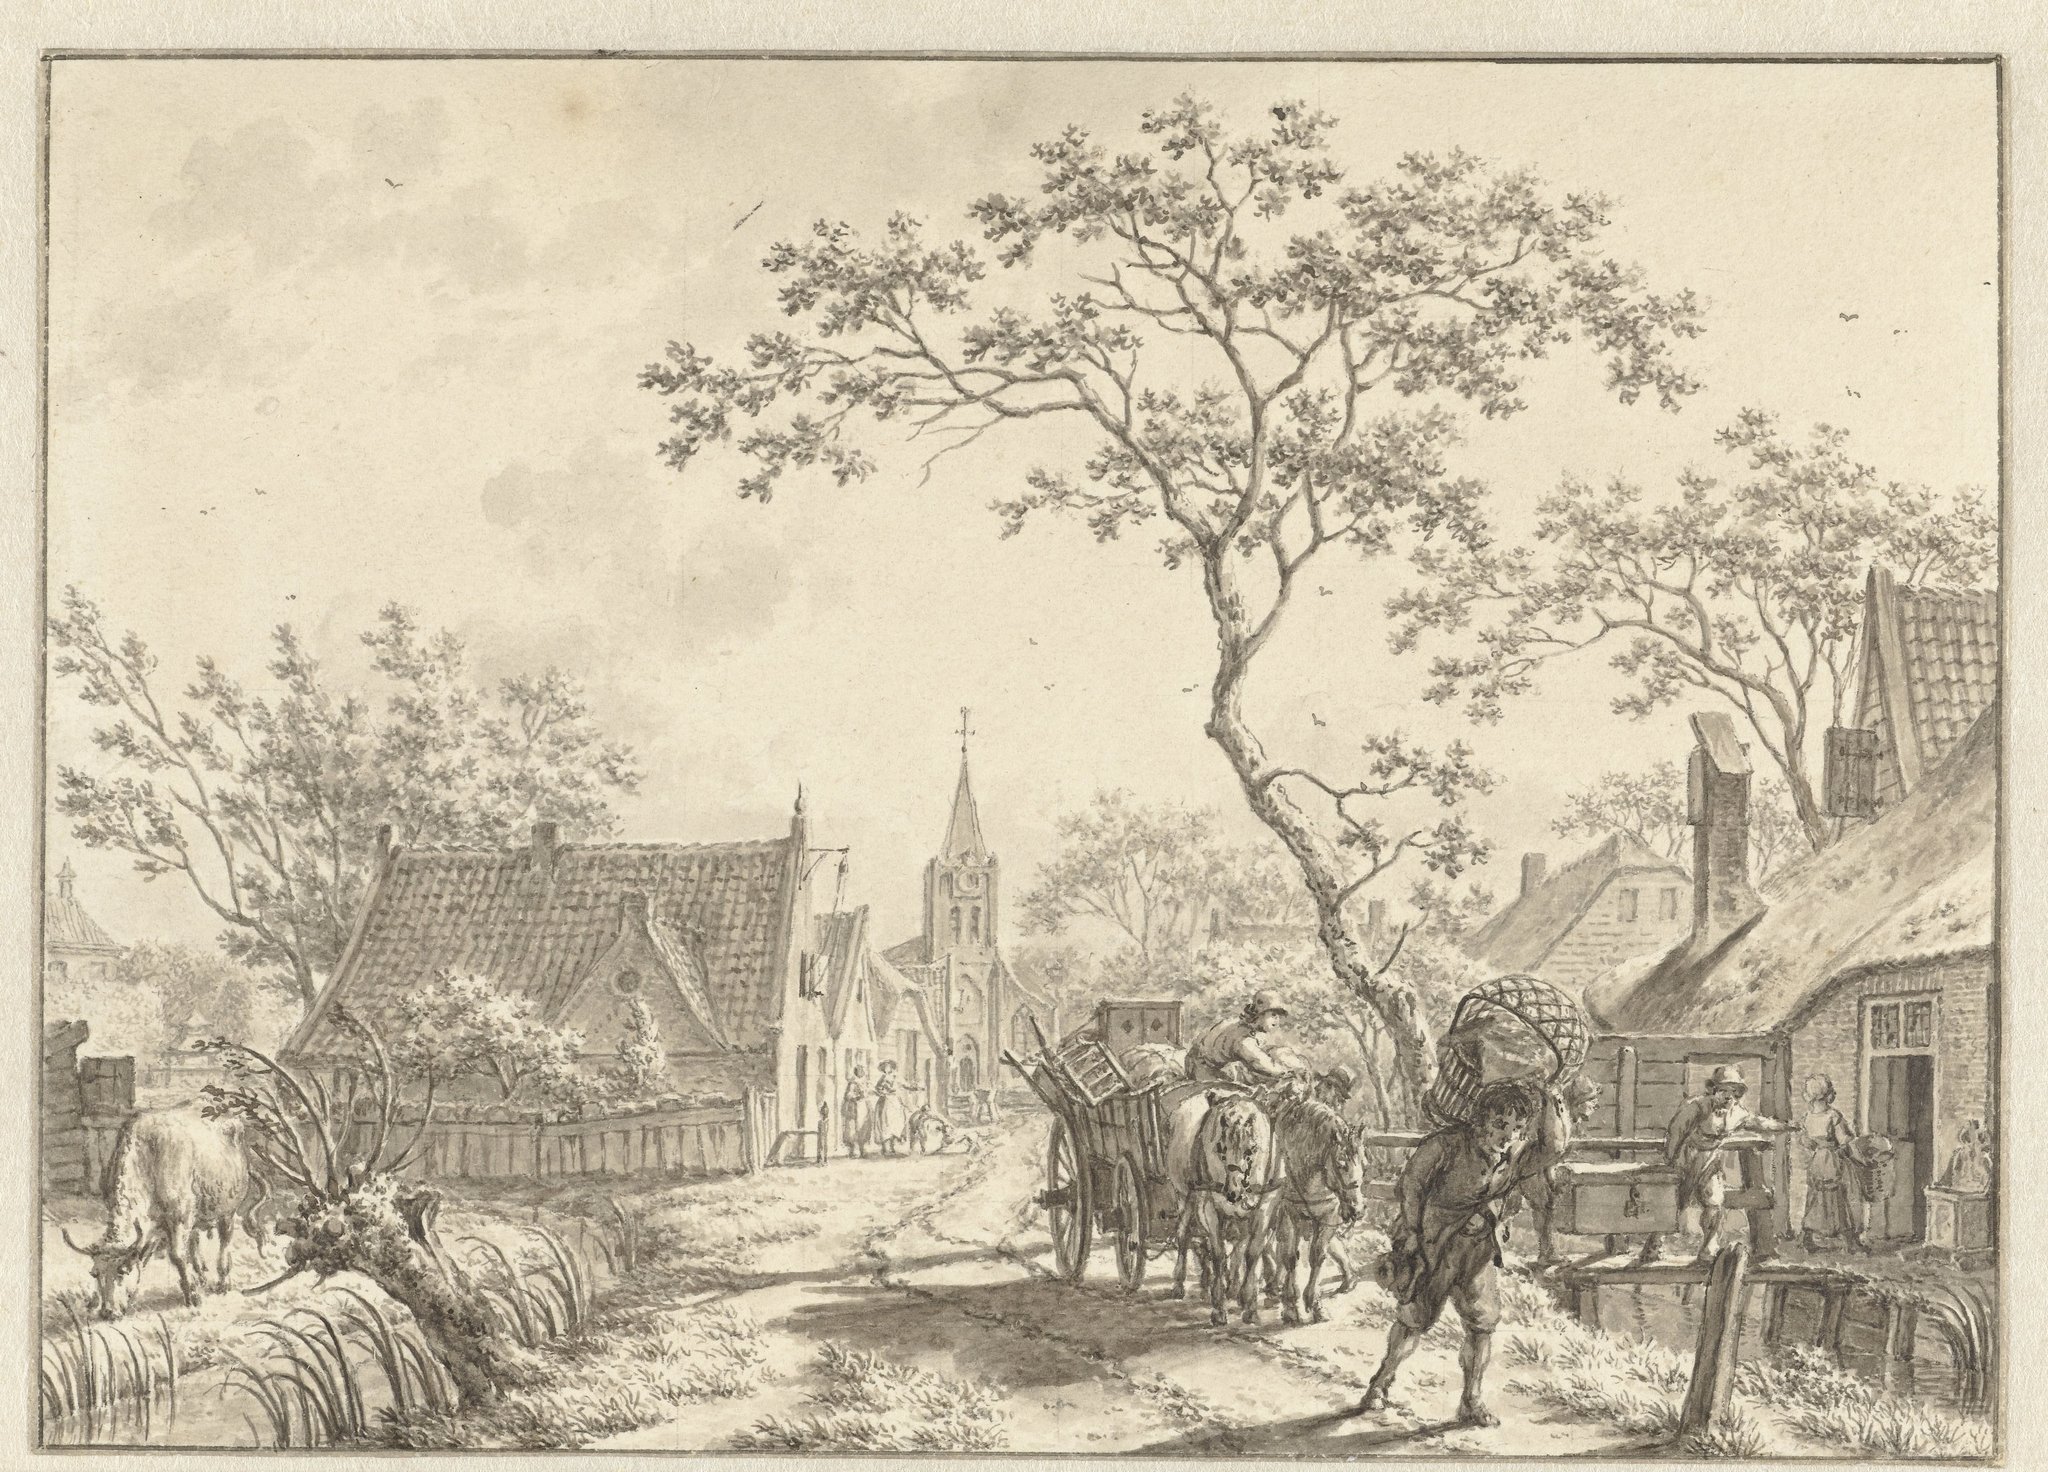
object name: drawing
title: Mei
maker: jacob cats (1741-1799)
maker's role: draughtsman, print maker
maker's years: 1741-1799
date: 1791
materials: ink, paper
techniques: brush, pen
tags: landscape symbolizing may